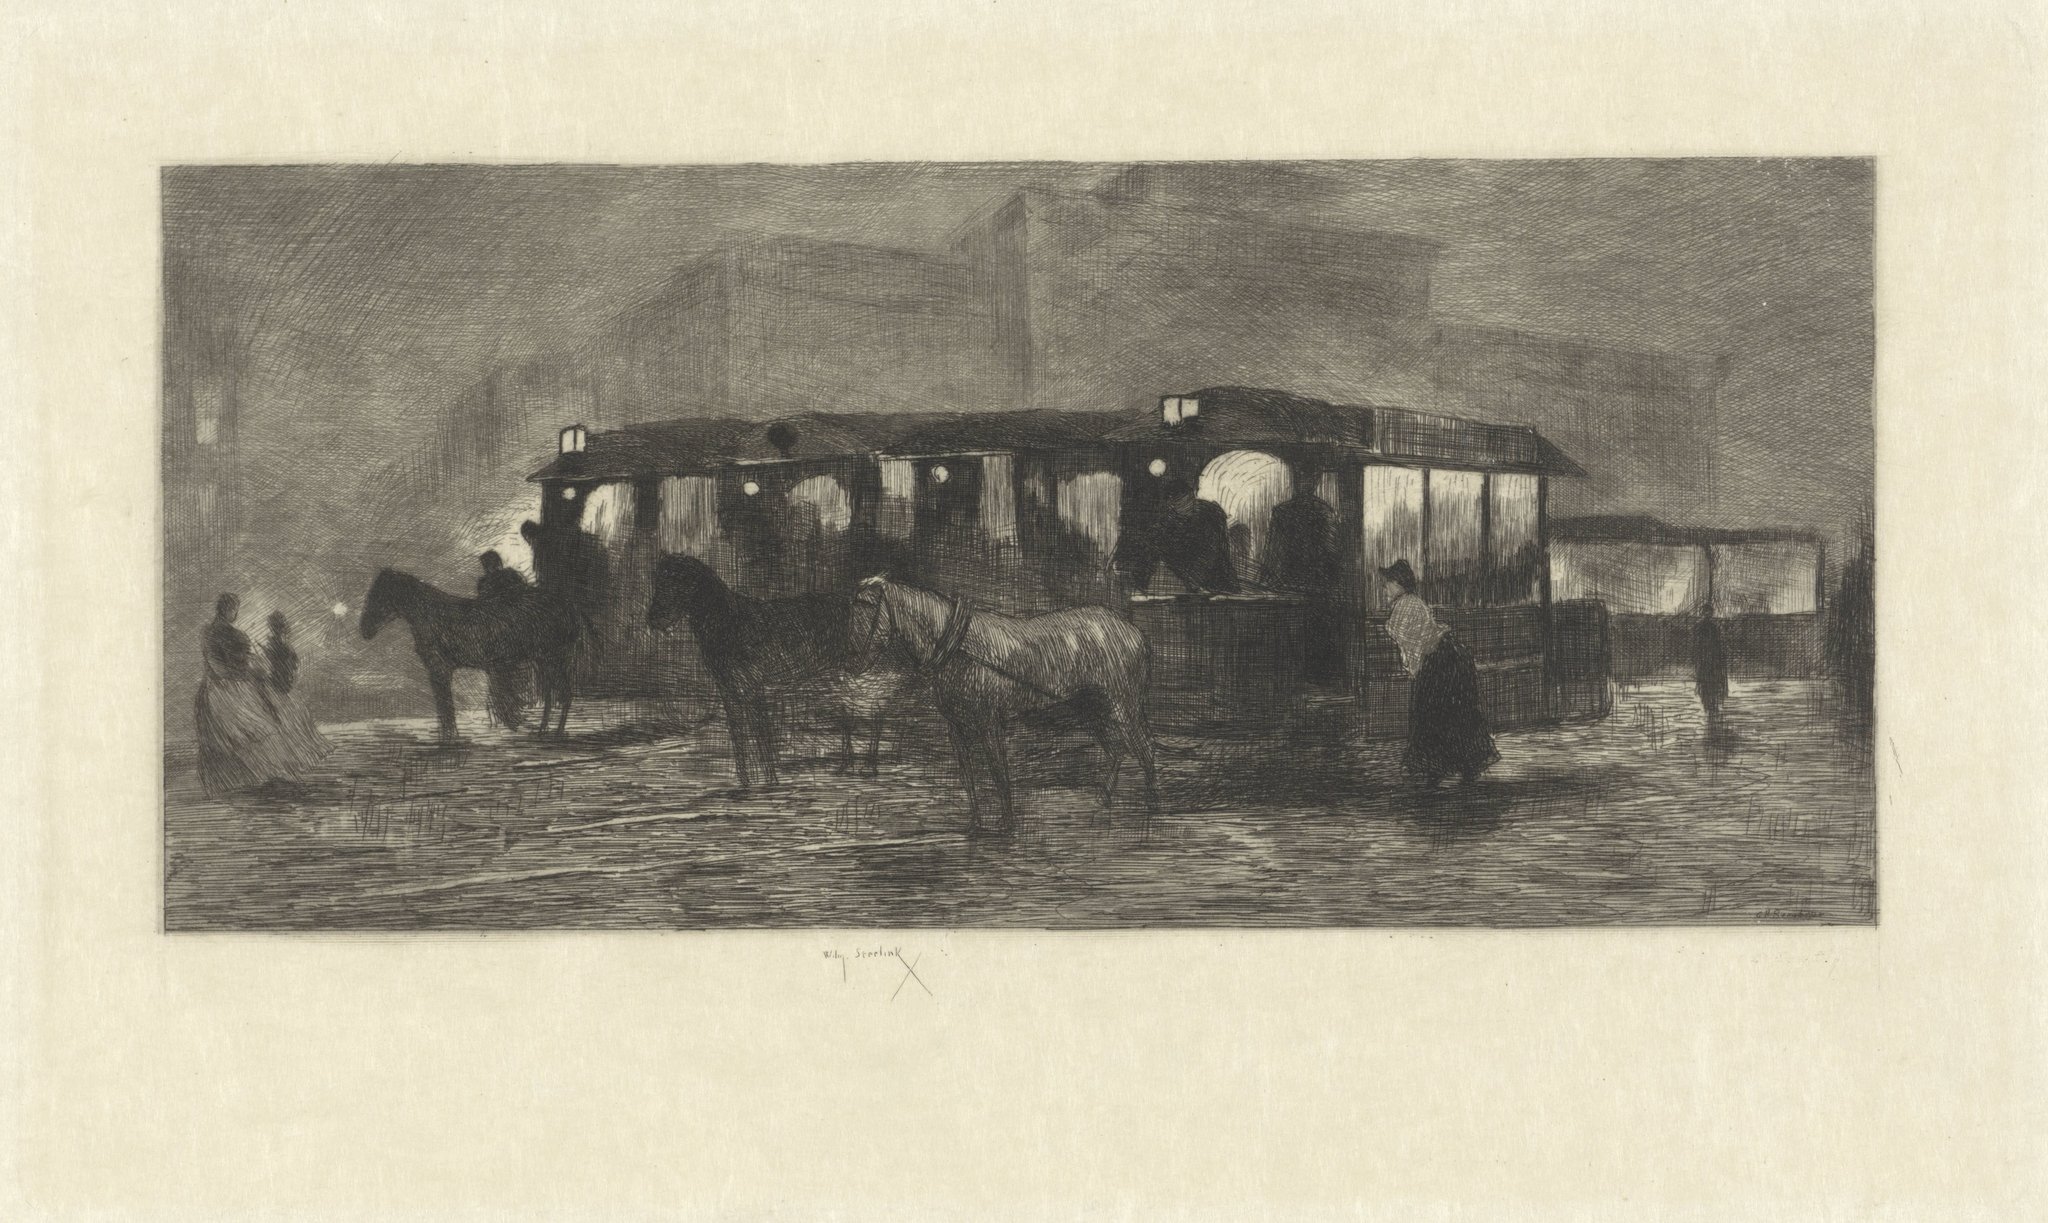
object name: print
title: Plein bij avond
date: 1889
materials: paper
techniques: etching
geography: netherlands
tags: diligence, omnibus, horse-tram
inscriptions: collector's mark: Lugt 2228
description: Op een plein bij avond staan paardentrams te wachten.